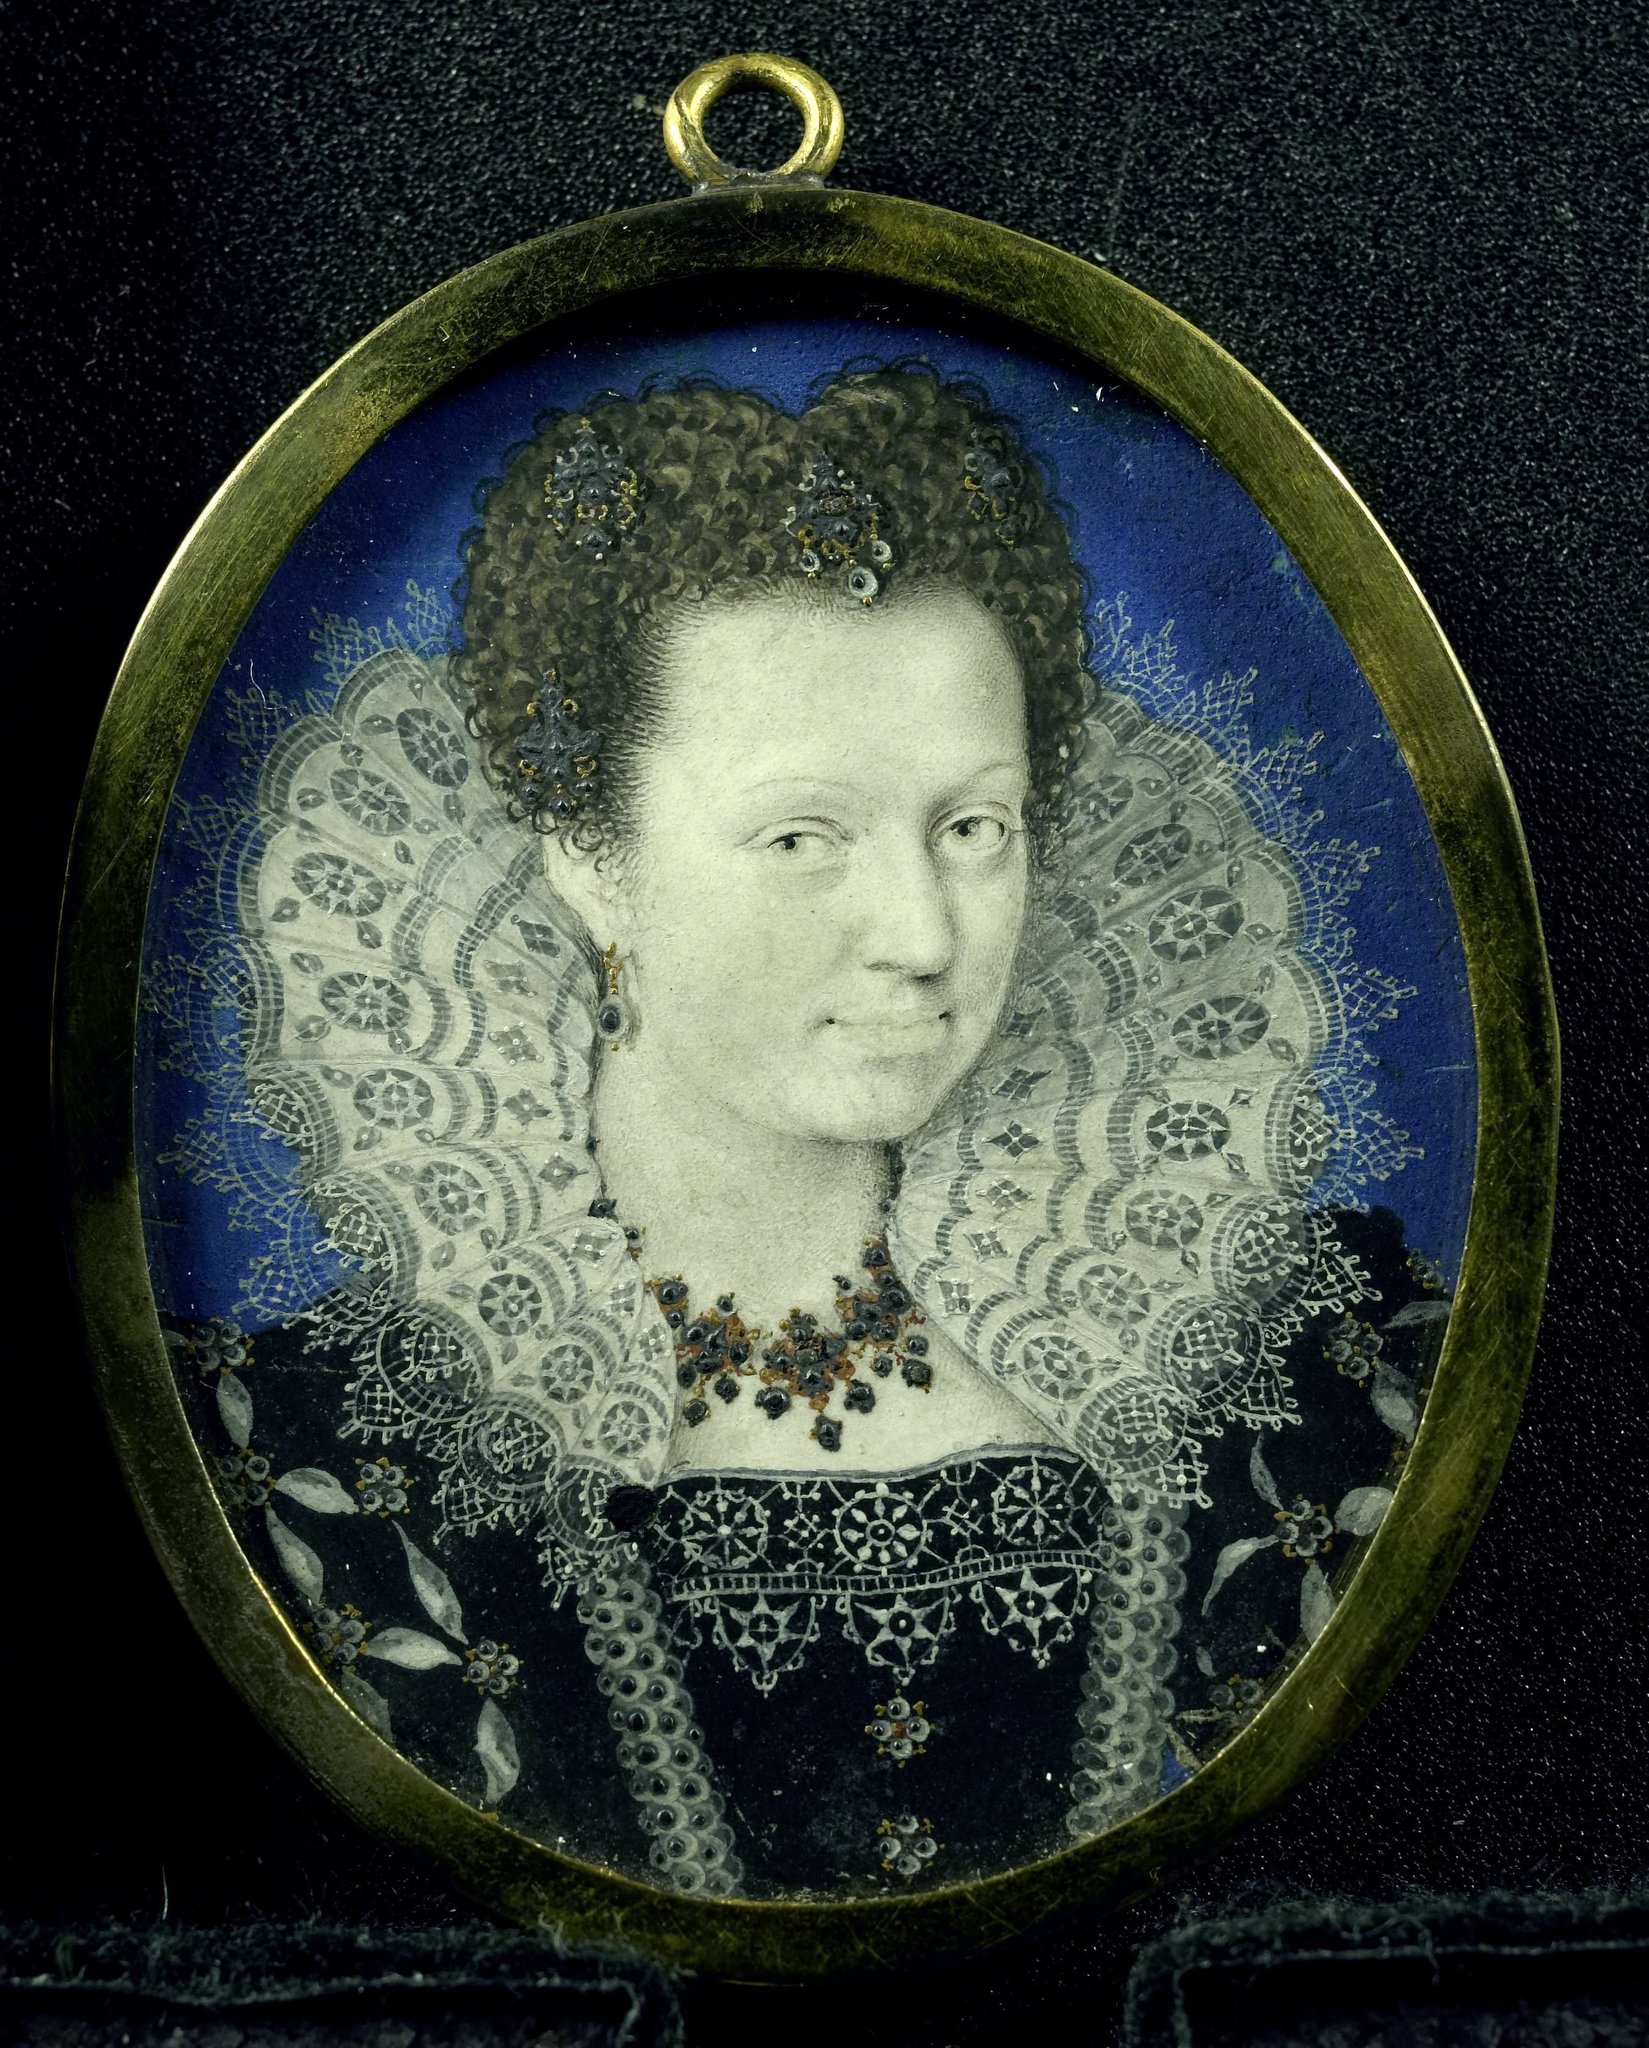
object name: painting, miniature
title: Portret van een vrouw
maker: isaac oliver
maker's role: draughtsman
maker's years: 1565-1617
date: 1575-1617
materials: glass, metal, parchment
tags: historical persons not known by name - bb - woman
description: Portret van een vrouw. Buste, naar rechts. Onderdeel van de collectie portretminiaturen.